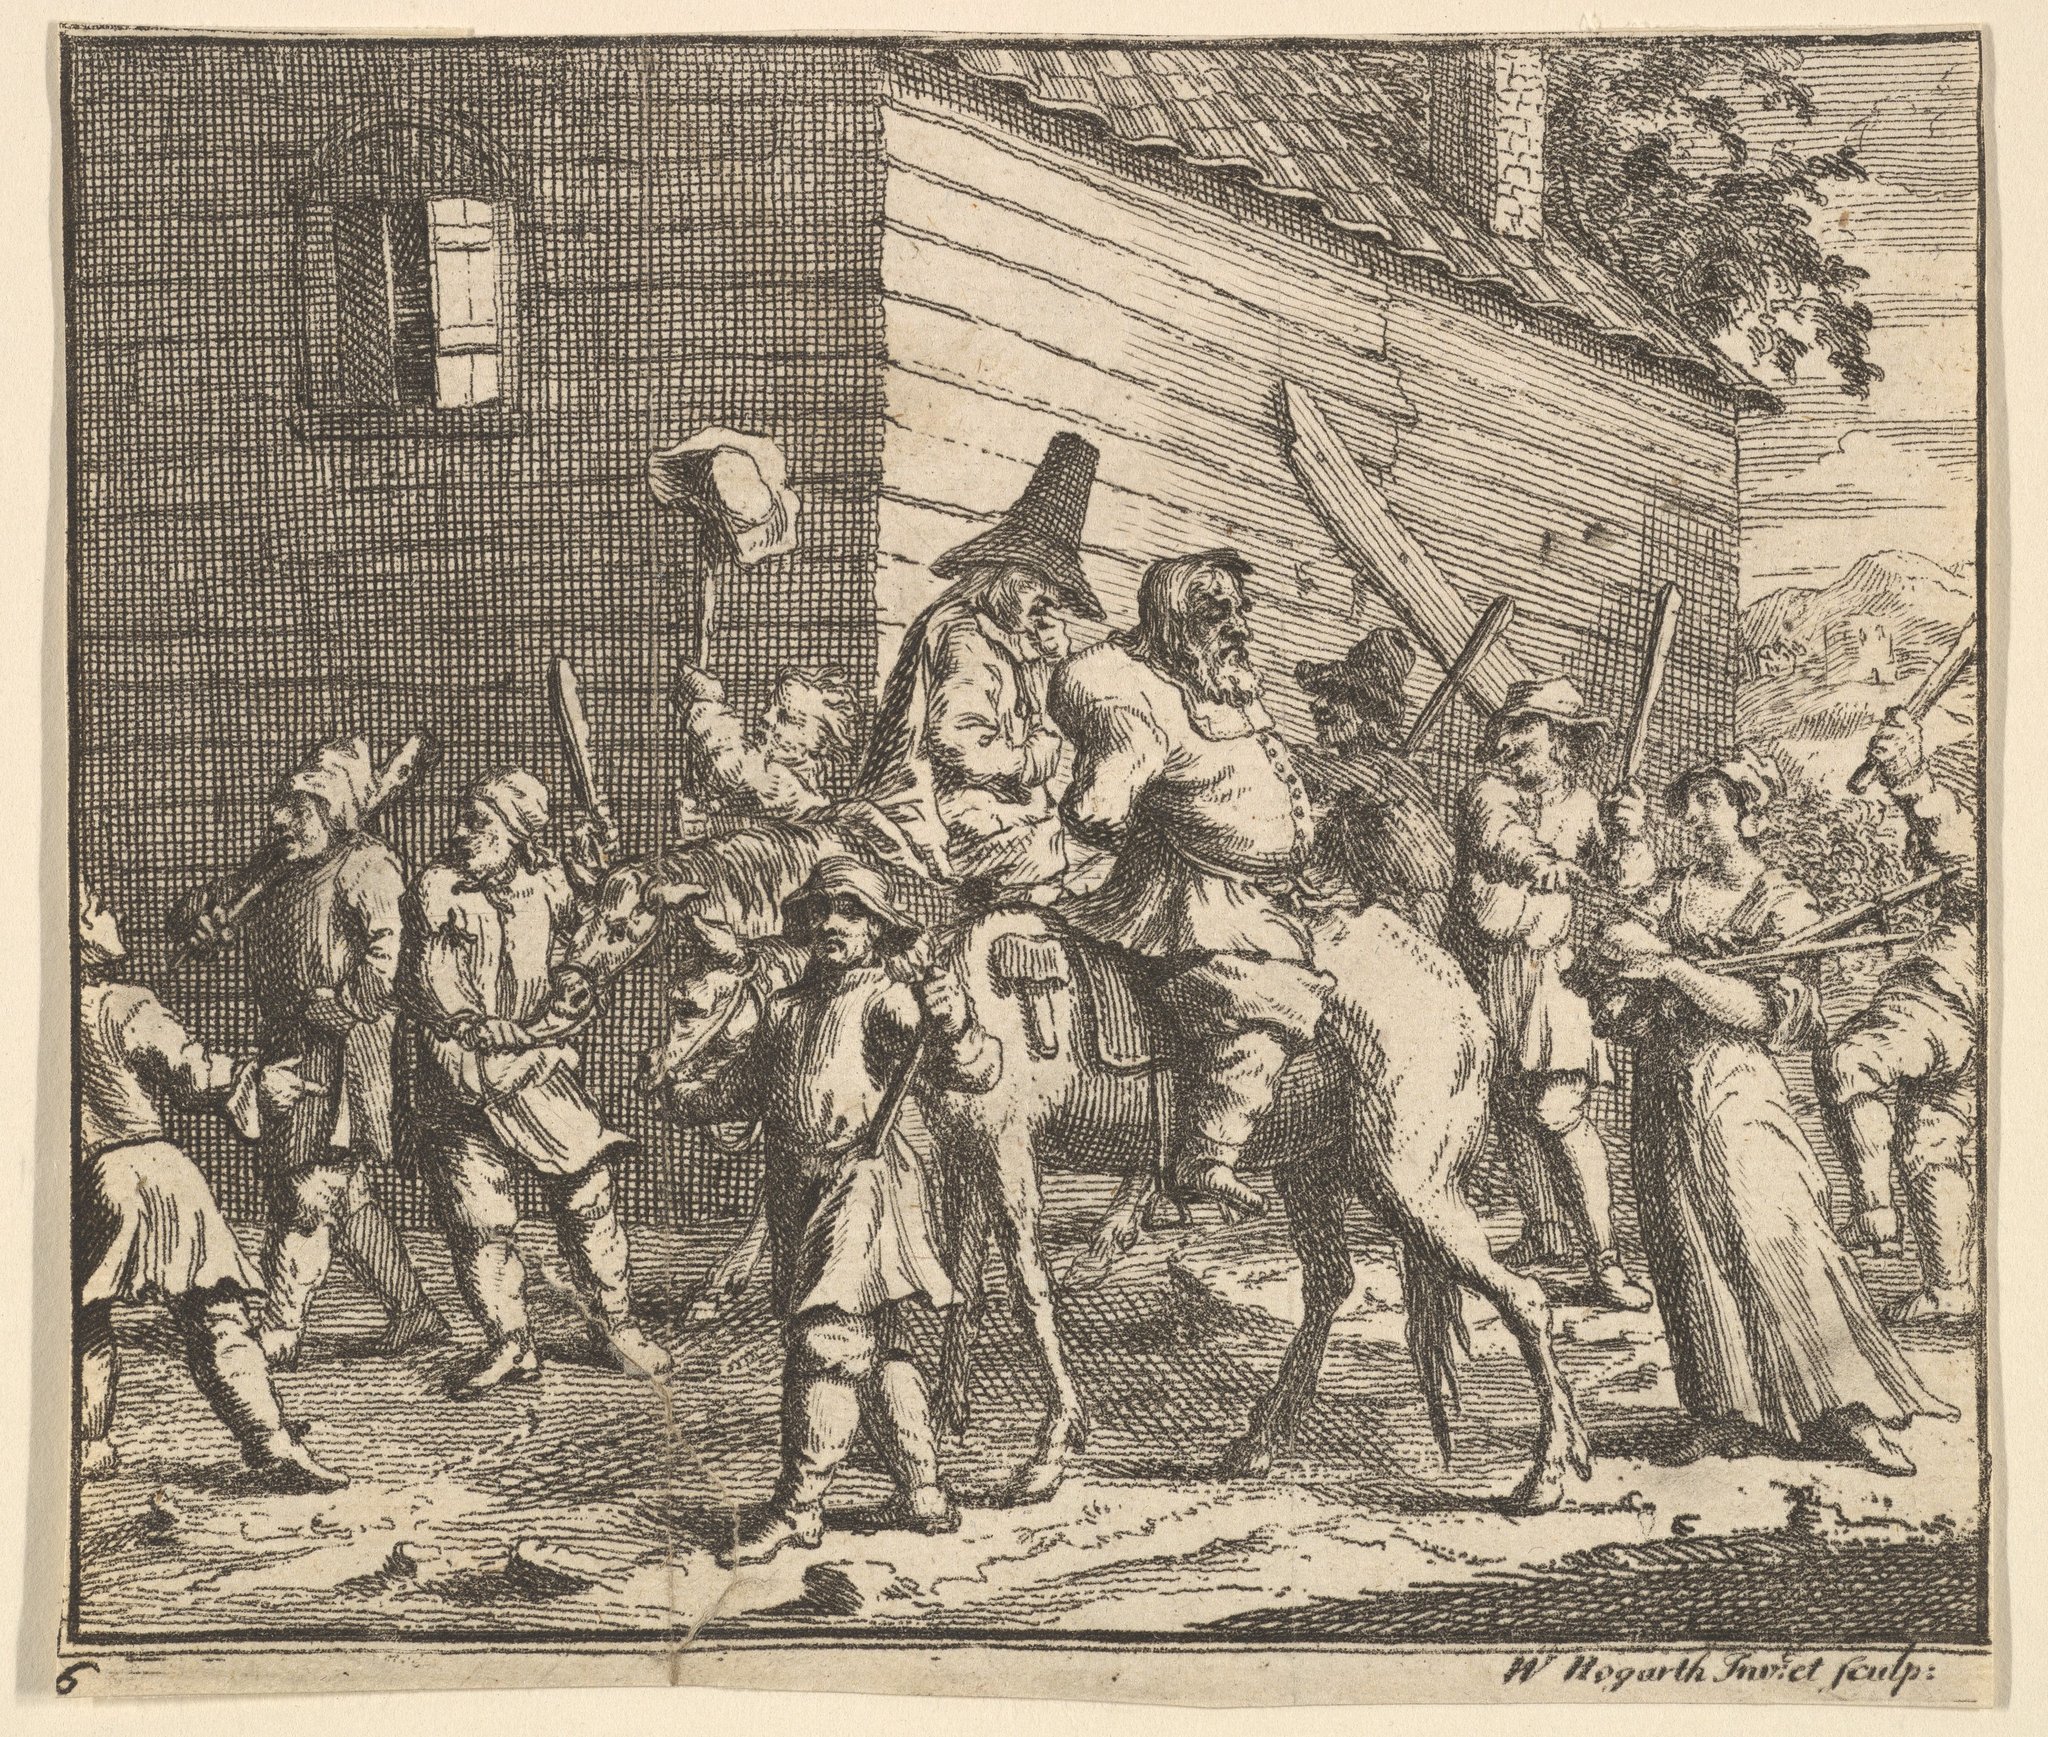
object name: print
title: Hudibras and Ralpho Made Prisoners and Carried to the Stocks (Seventeen Small Illustrations for Samuel Butler's Hudibras, no. 6)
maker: william hogarth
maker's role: artist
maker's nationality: british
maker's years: 1697-1764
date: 1721-1726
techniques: engraving, etching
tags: animals,buildings,prisoners,men,women